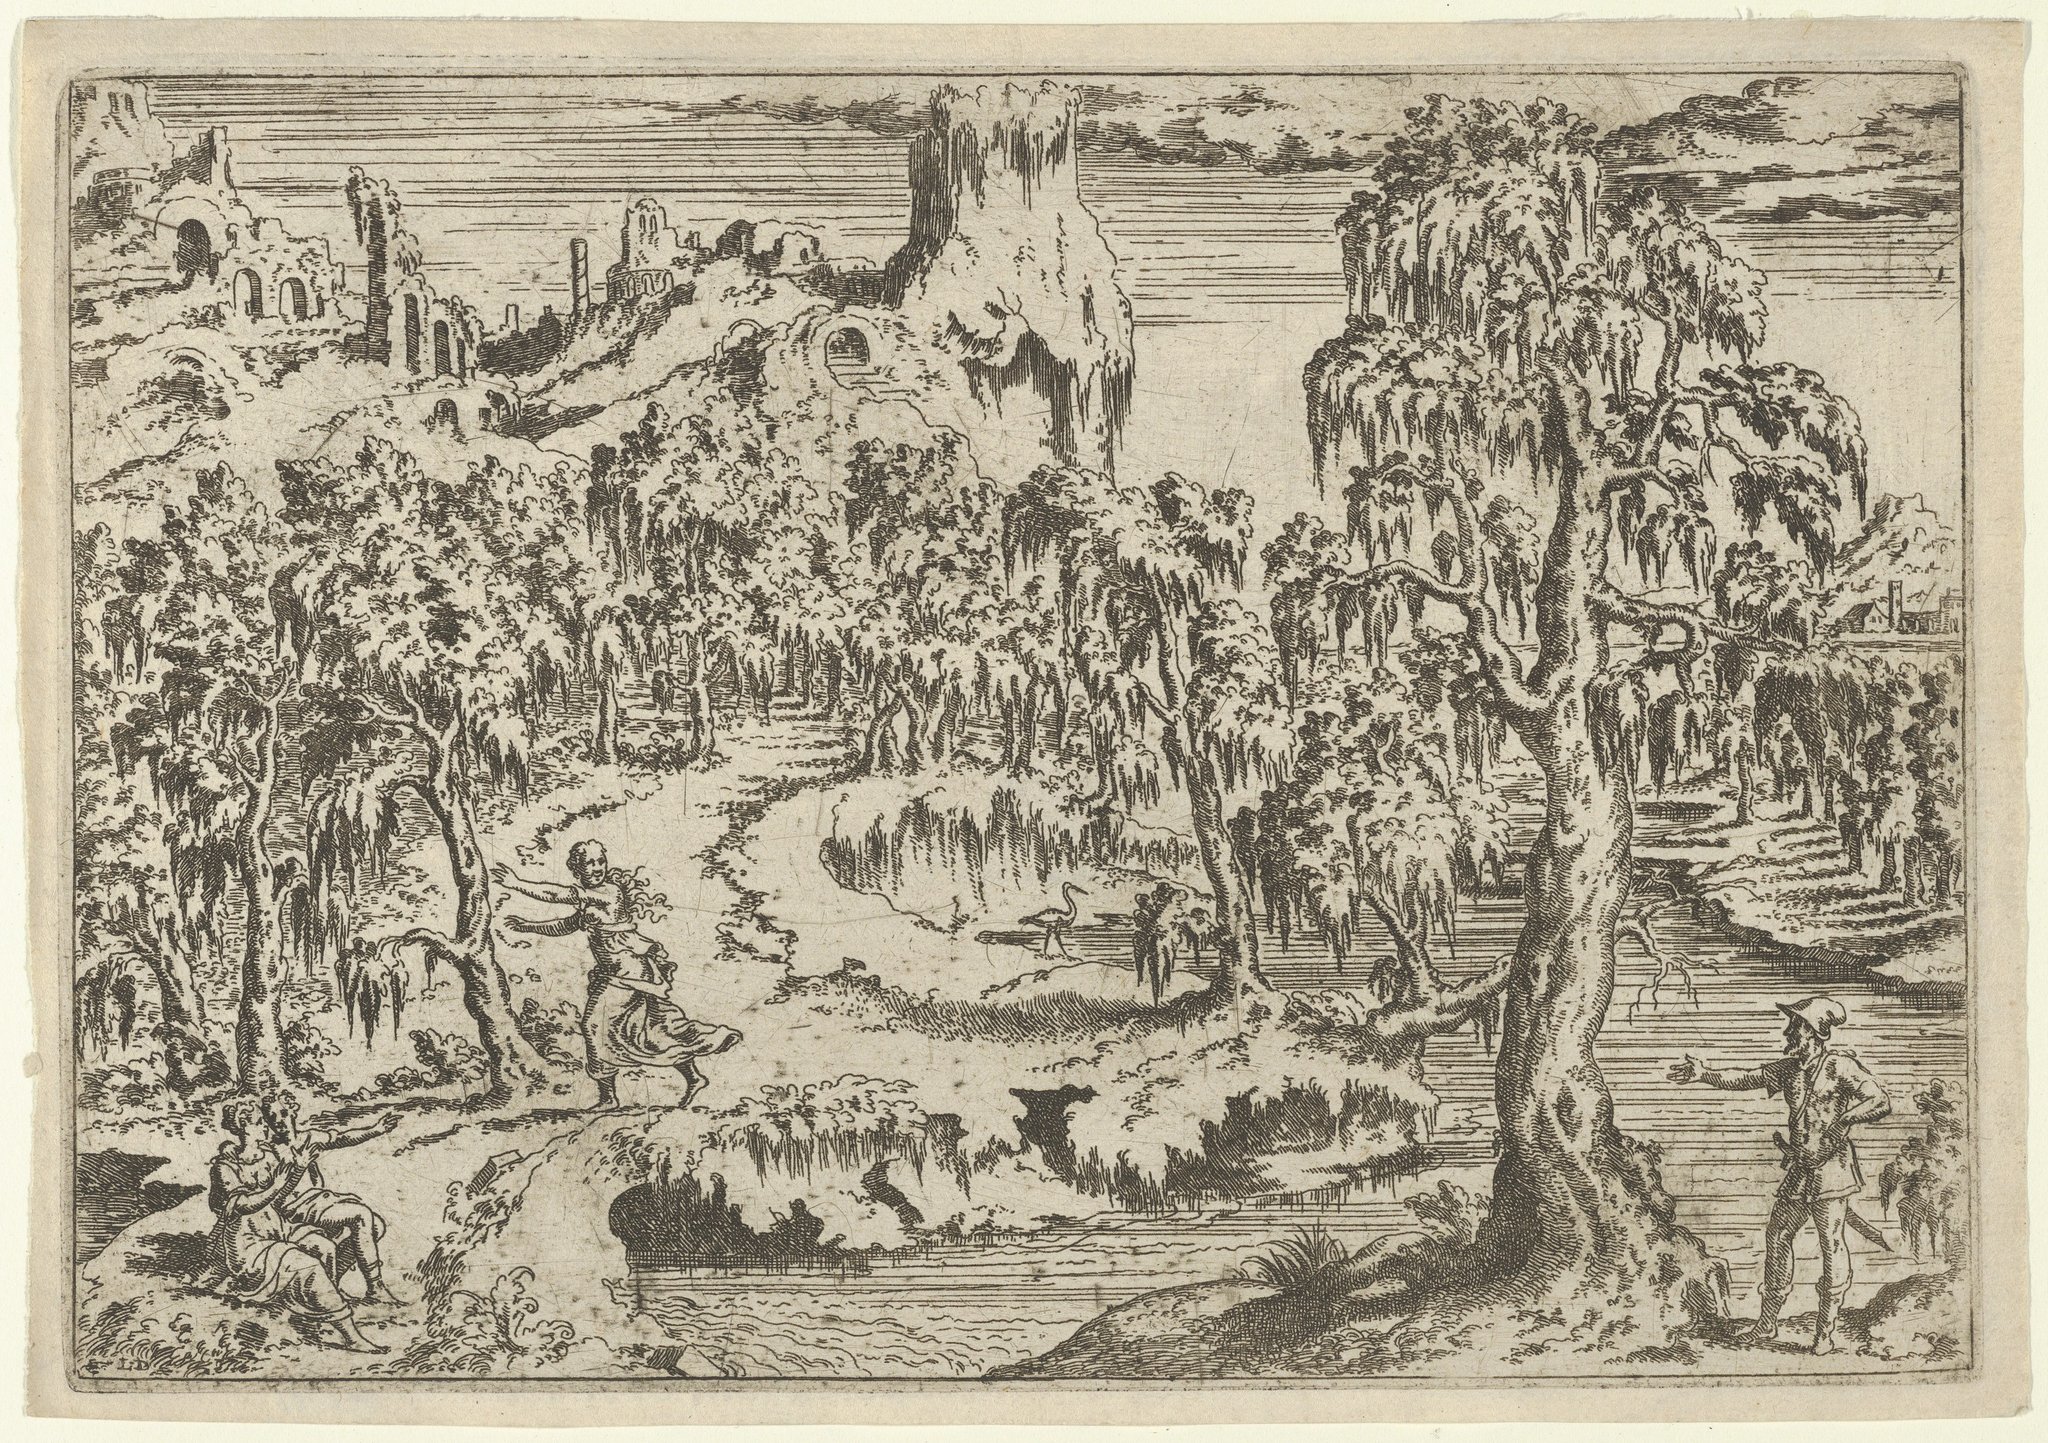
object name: print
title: A Man Armed with a Saber Gestures Toward a Fleeing Woman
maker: léon davent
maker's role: artist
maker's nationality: french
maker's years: 1540-1556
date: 1540-1556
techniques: etching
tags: men,women,landscapes,trees